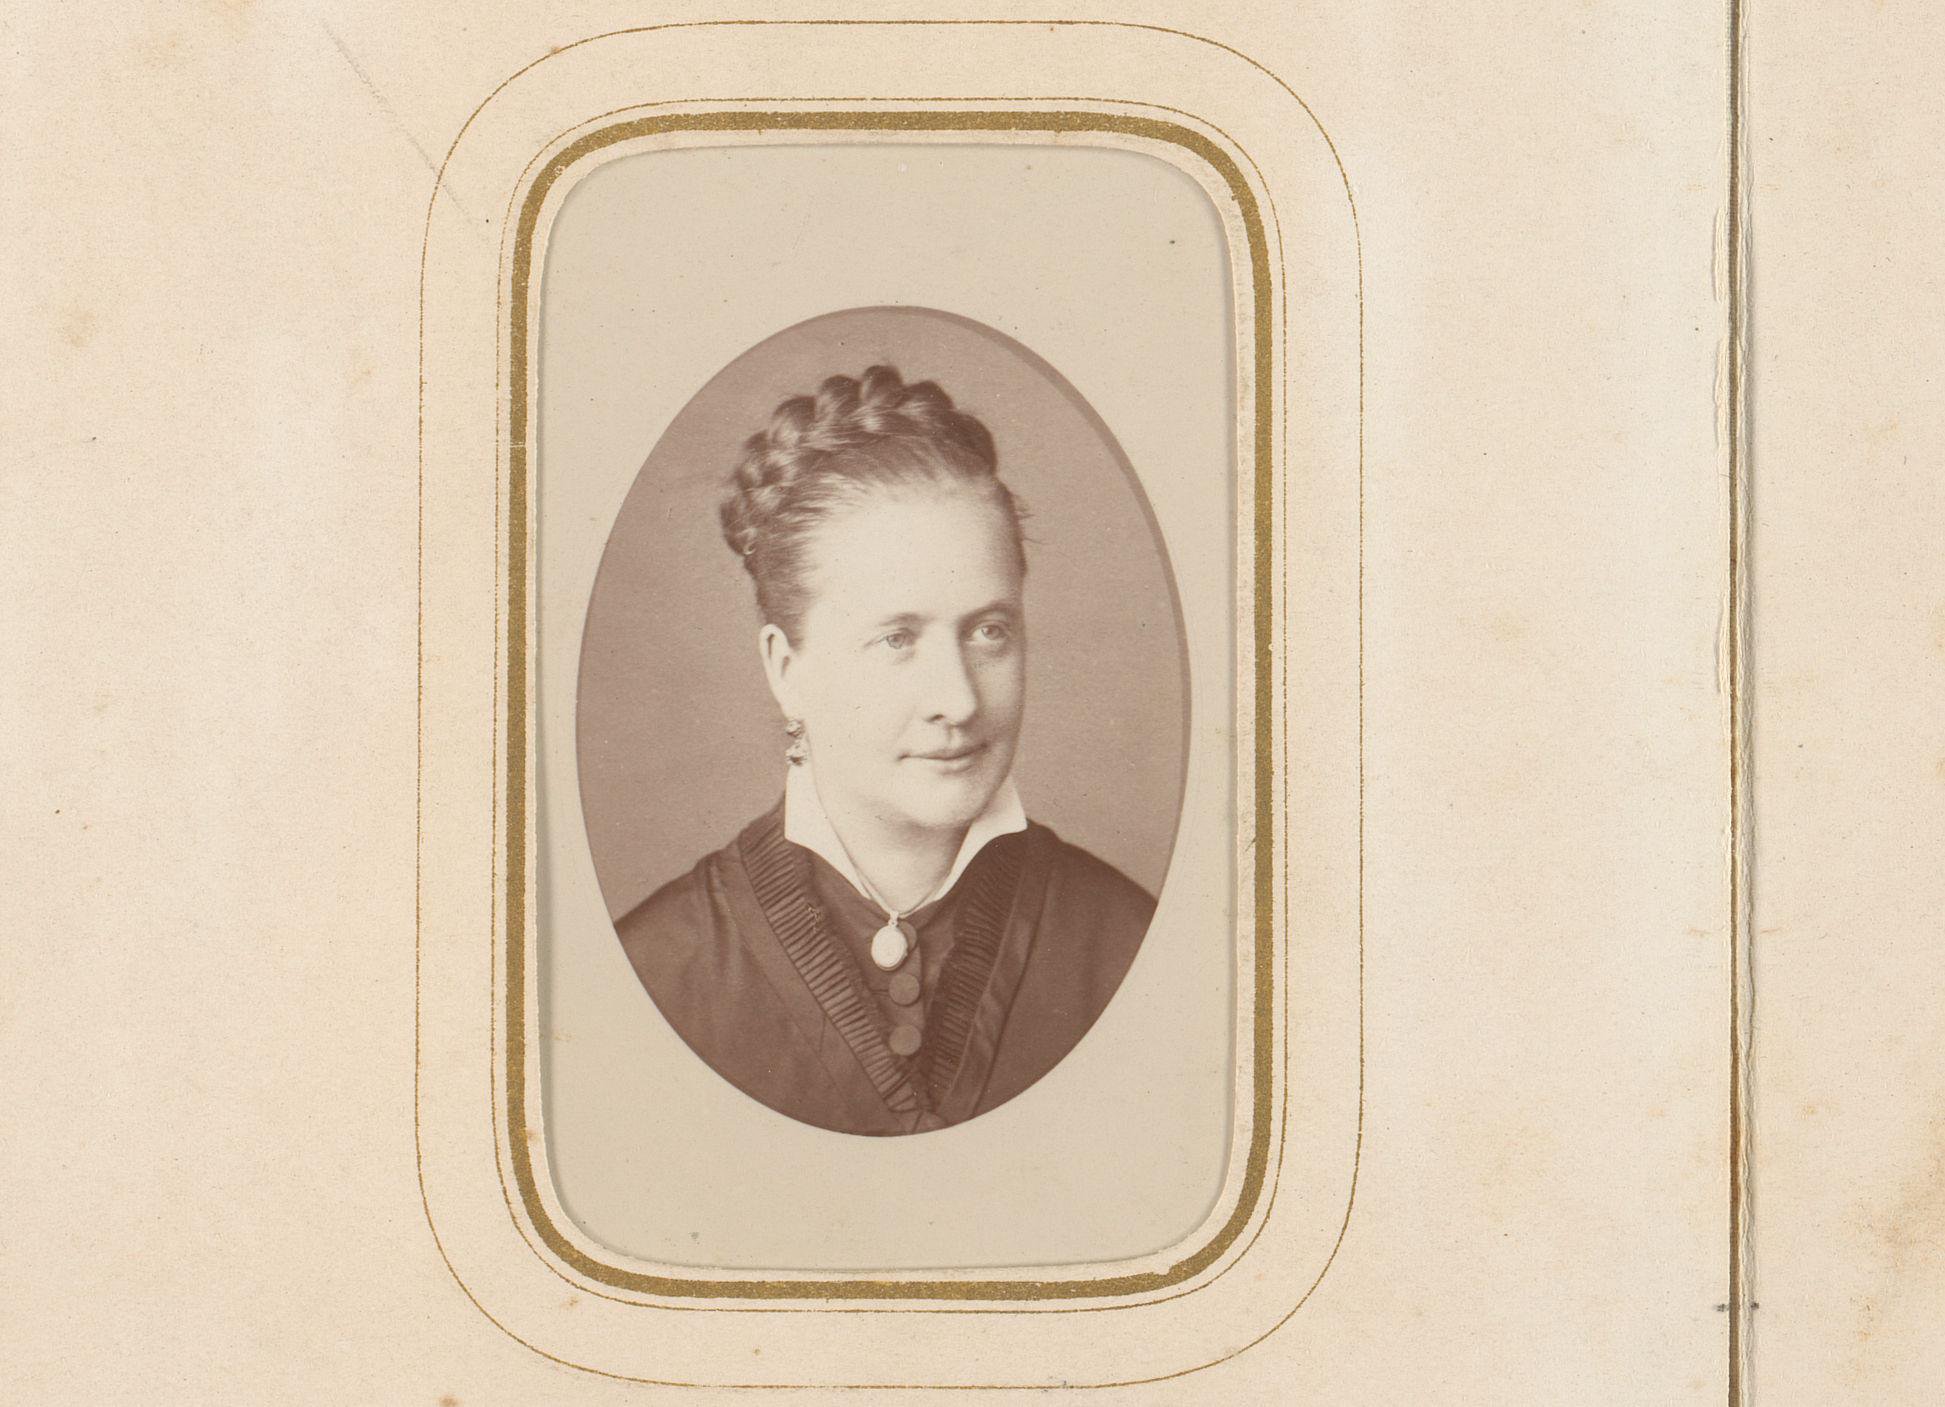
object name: album leaf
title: Portret van een vrouw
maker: ulric grob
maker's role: fotograaf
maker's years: 1823-1893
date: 1880-1900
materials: cardboard, photographic support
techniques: albumen print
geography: paris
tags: historical persons - bb - woman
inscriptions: inscription: ‘Ulric Grob’, inscription: ‘Ulric Grob/ 29, Boulevart St. Martin, 29/ Entrée par le Grand Escalier/ Ci-devant, 2, Boulevart Montmartre/ Hôtel d'Or/ Paris’